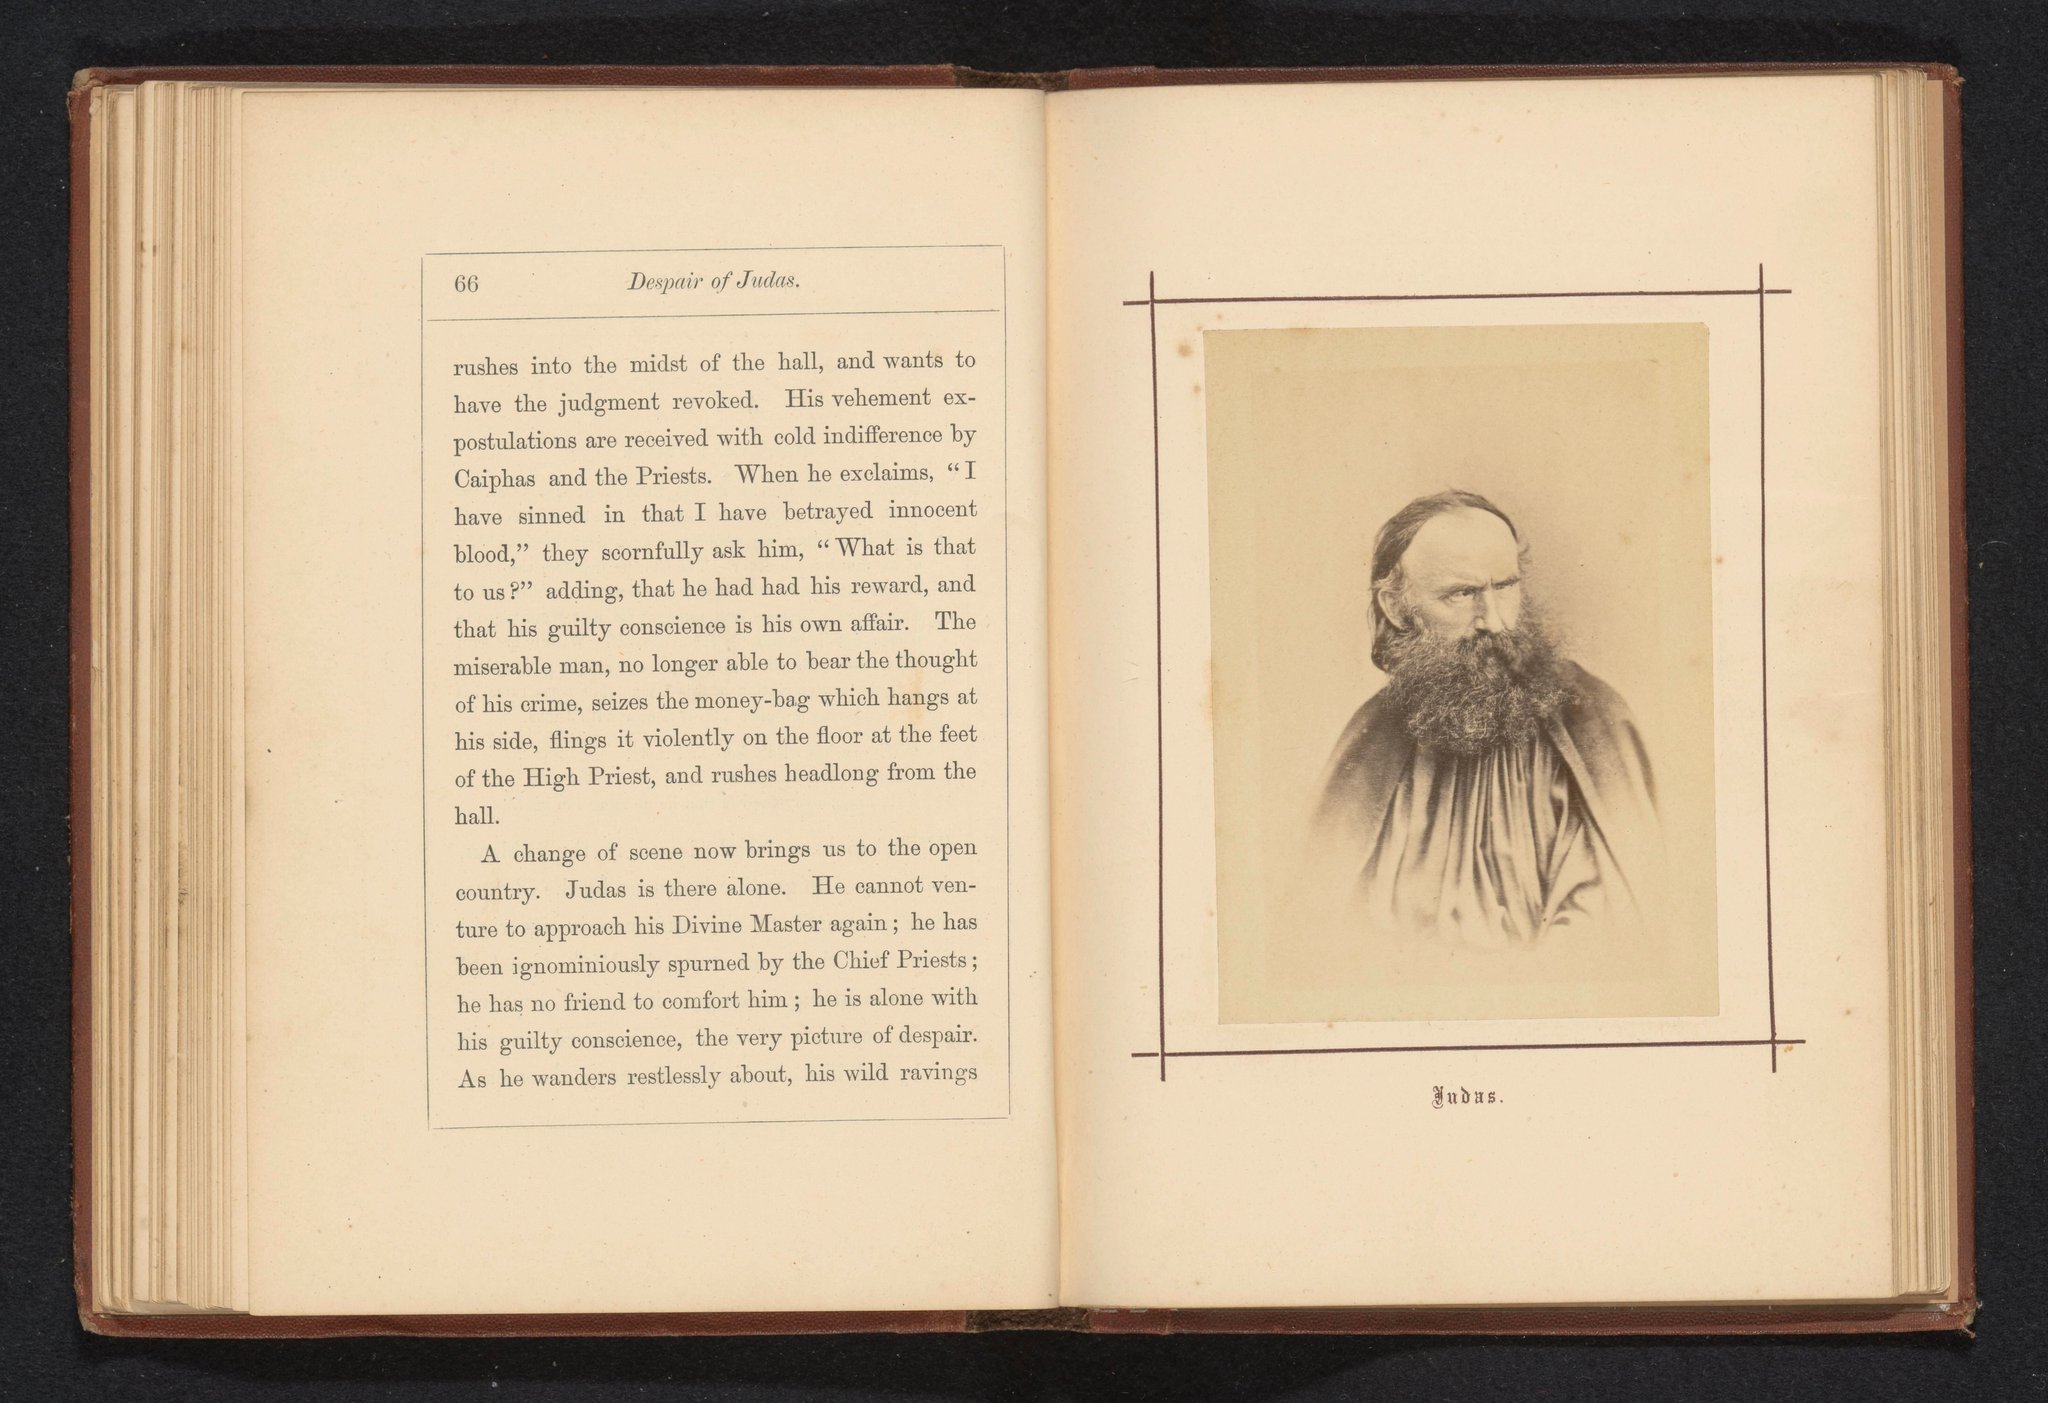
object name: photograph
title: Judas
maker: joseph albert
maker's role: printer, publisher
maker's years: 1825-1886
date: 1871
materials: photographic support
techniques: albumen print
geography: oberammergau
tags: judas iscariot (not in biblical context)